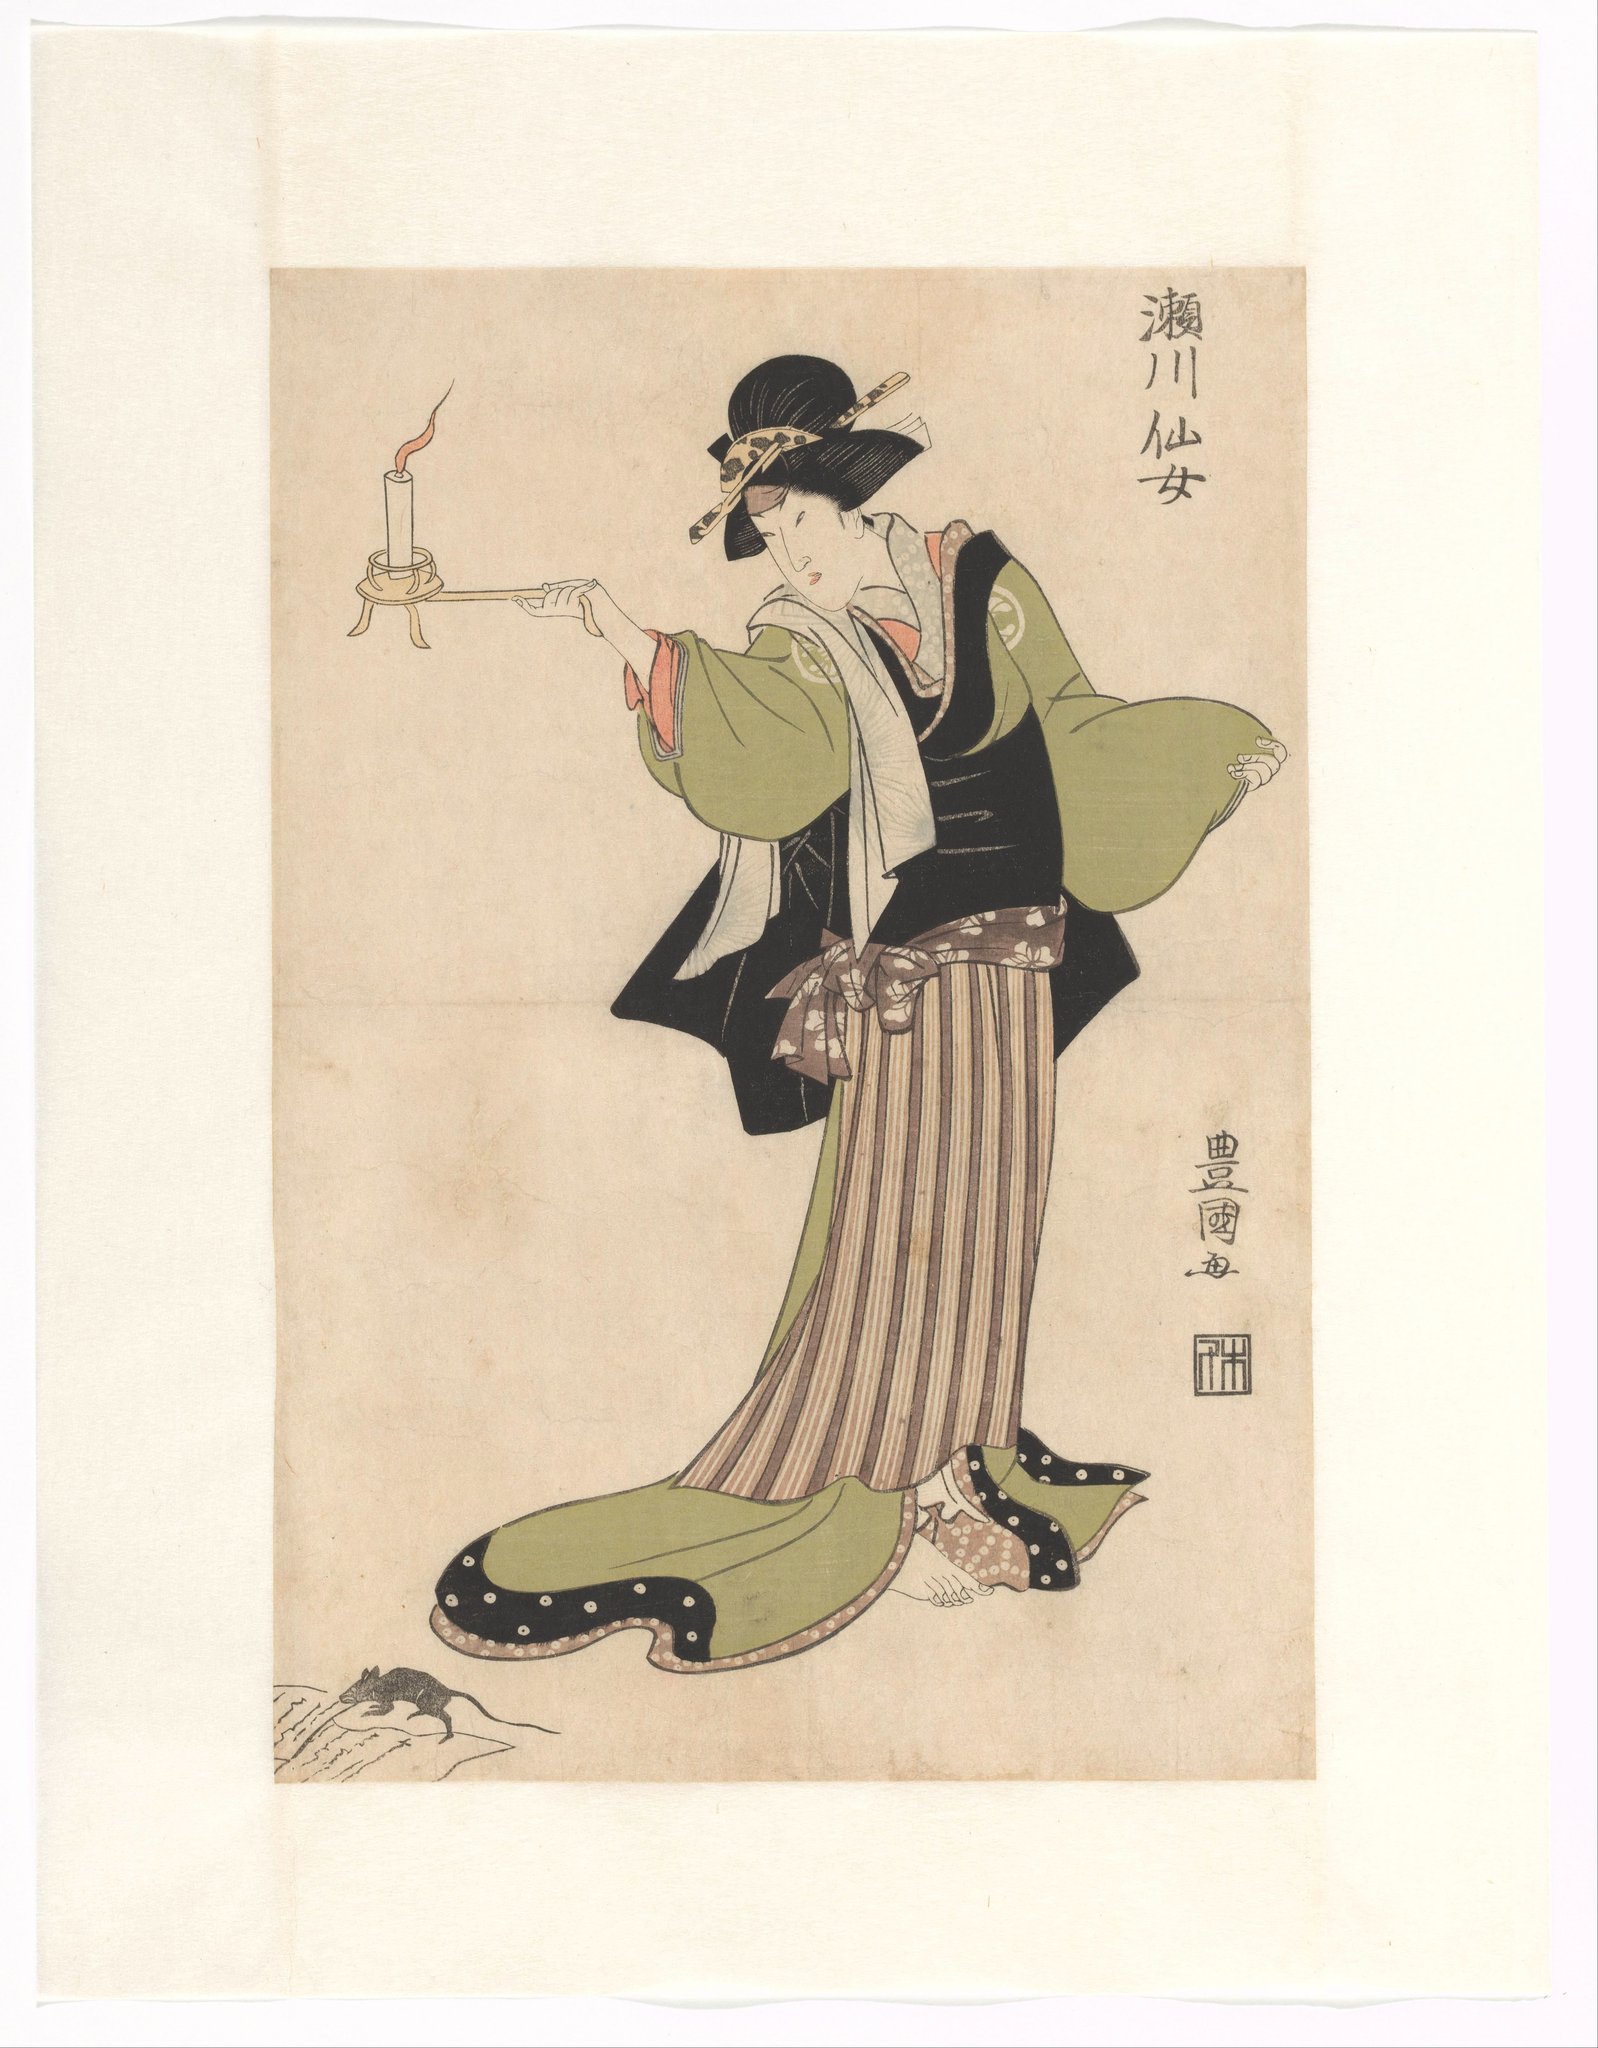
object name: print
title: Segawa Senjo in the role of nurse Masaoka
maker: utagawa toyokuni (i)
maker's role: print maker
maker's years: 1769-1825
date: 1809-1810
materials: paper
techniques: woodcut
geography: japan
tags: rodents: rat, candle, actor (on the stage)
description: Kabuki acteur Segawa Senjo in de rol van het kindermeisje Masaoka. Bij het licht van de kaars in haar hand, ziet ze een rat documenten stelen.